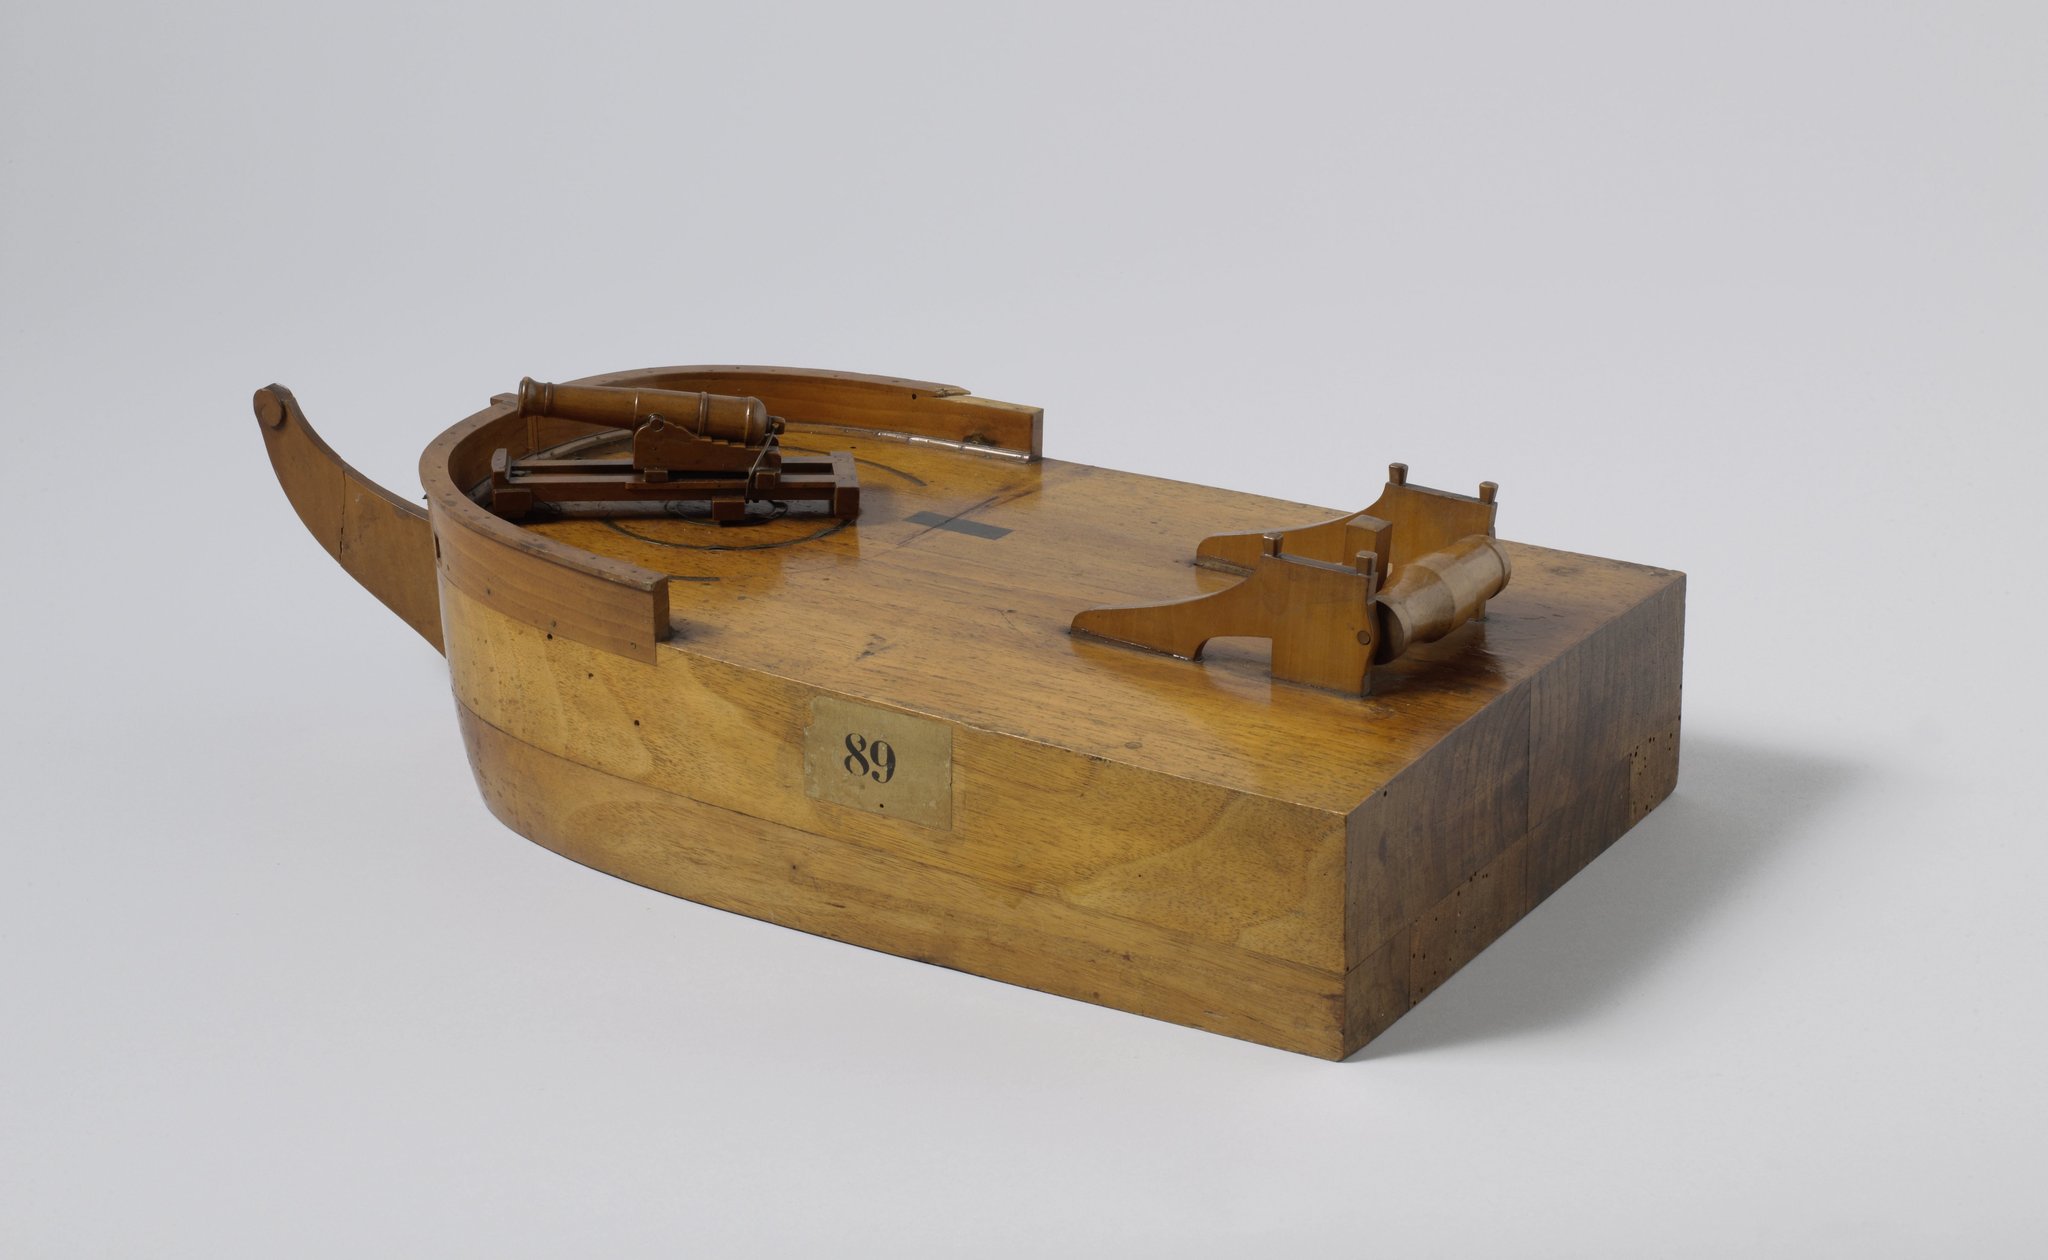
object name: demonstration model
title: Model of Two Different Designs for the Gun Position on the Bow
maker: Anonymous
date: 1840-1850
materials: brass, wood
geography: netherlands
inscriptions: label, on the side: ‘89’ former inventory label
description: Schetsmatig blokmodel en waterlijnmodel van een voorschip met bomkanon op draaislede, incompleet. Het heeft een scheg, de boegspriet en kraanbalken ontbreken, en achterop is een braadspil aangebracht. Het kanon met draaislede draait op in het dek ingelaten messing draaicirkels: een grote cirkel in het midden, en kleine draaicirkels aan weerszijden van de boeg. Vage krassen en nageltjes in het dek geven andere mogelijke rail-posities aan. De kluisgaten zijn met zwarte verf aangegeven. Zij bevinden zich benedendeks en de ankerkettingen of -trossen moeten door kokers naar de braadspil op het bovendek geleid worden; een zwarte rechthoek op het bovendek geeft waarschijnlijk de positie aan waar de koker bovendeks komt.